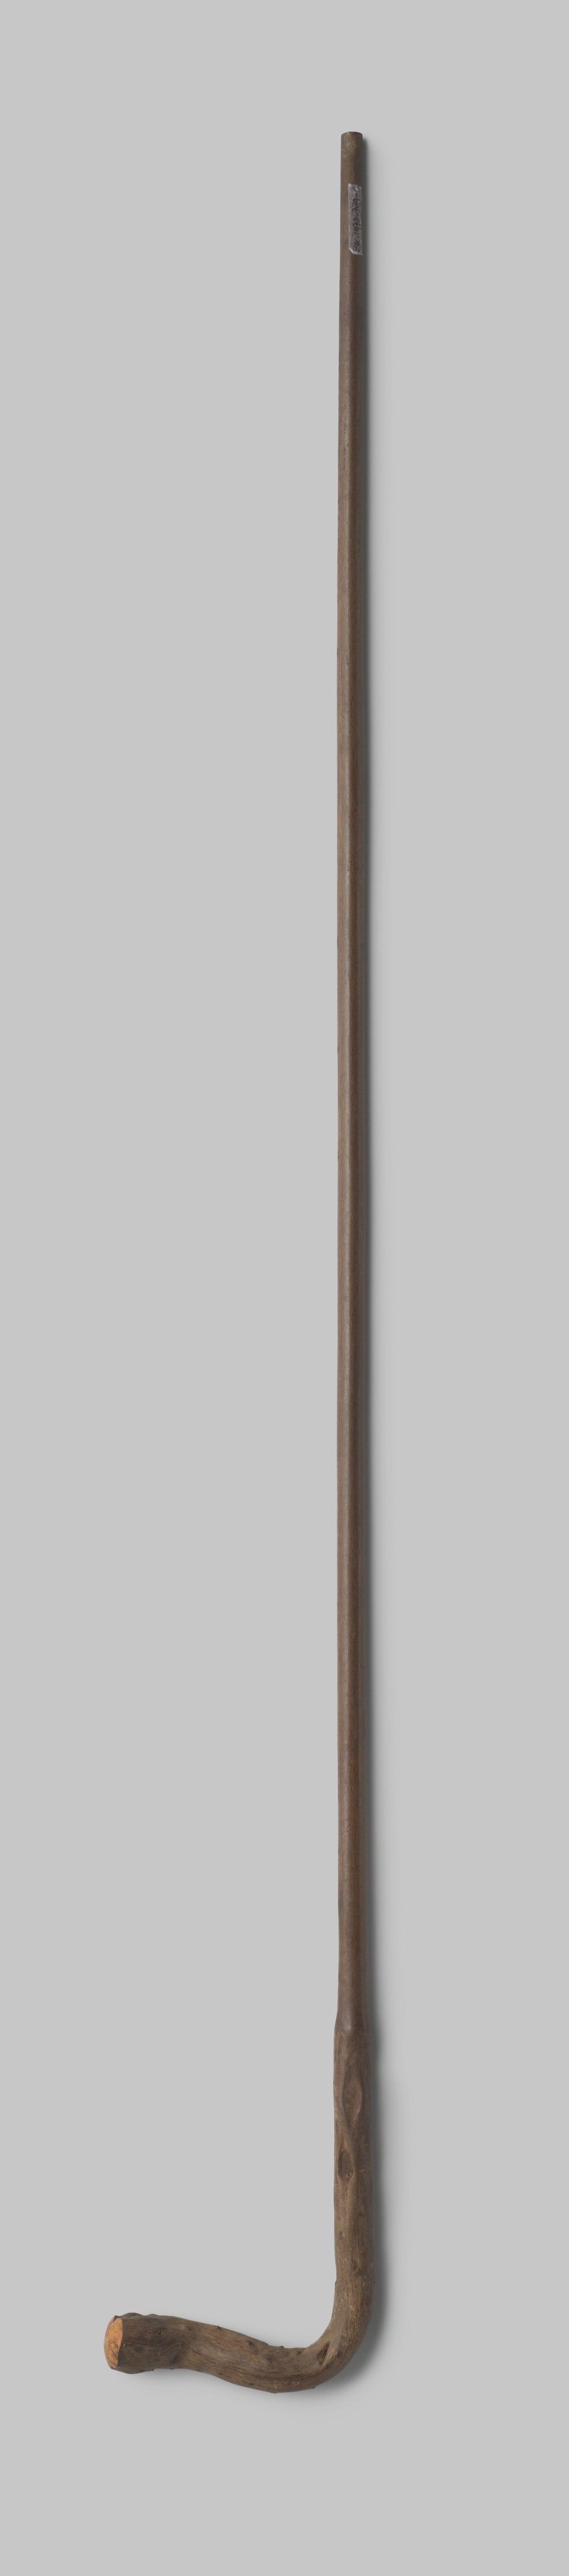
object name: onderstok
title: Onderstok van parapluie of parasol van gekleurd berkenhout met knoestige, rechte haak van gekleurd, warrig esdoorn(?)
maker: gustav schnitzler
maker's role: paraplufabrikant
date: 1920-1940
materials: wood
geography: nijmegen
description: Onderstok van parapluie of parasol van gekleurd berkenhout met knoestige, rechte haak van gekleurd, warrig esdoorn(?).